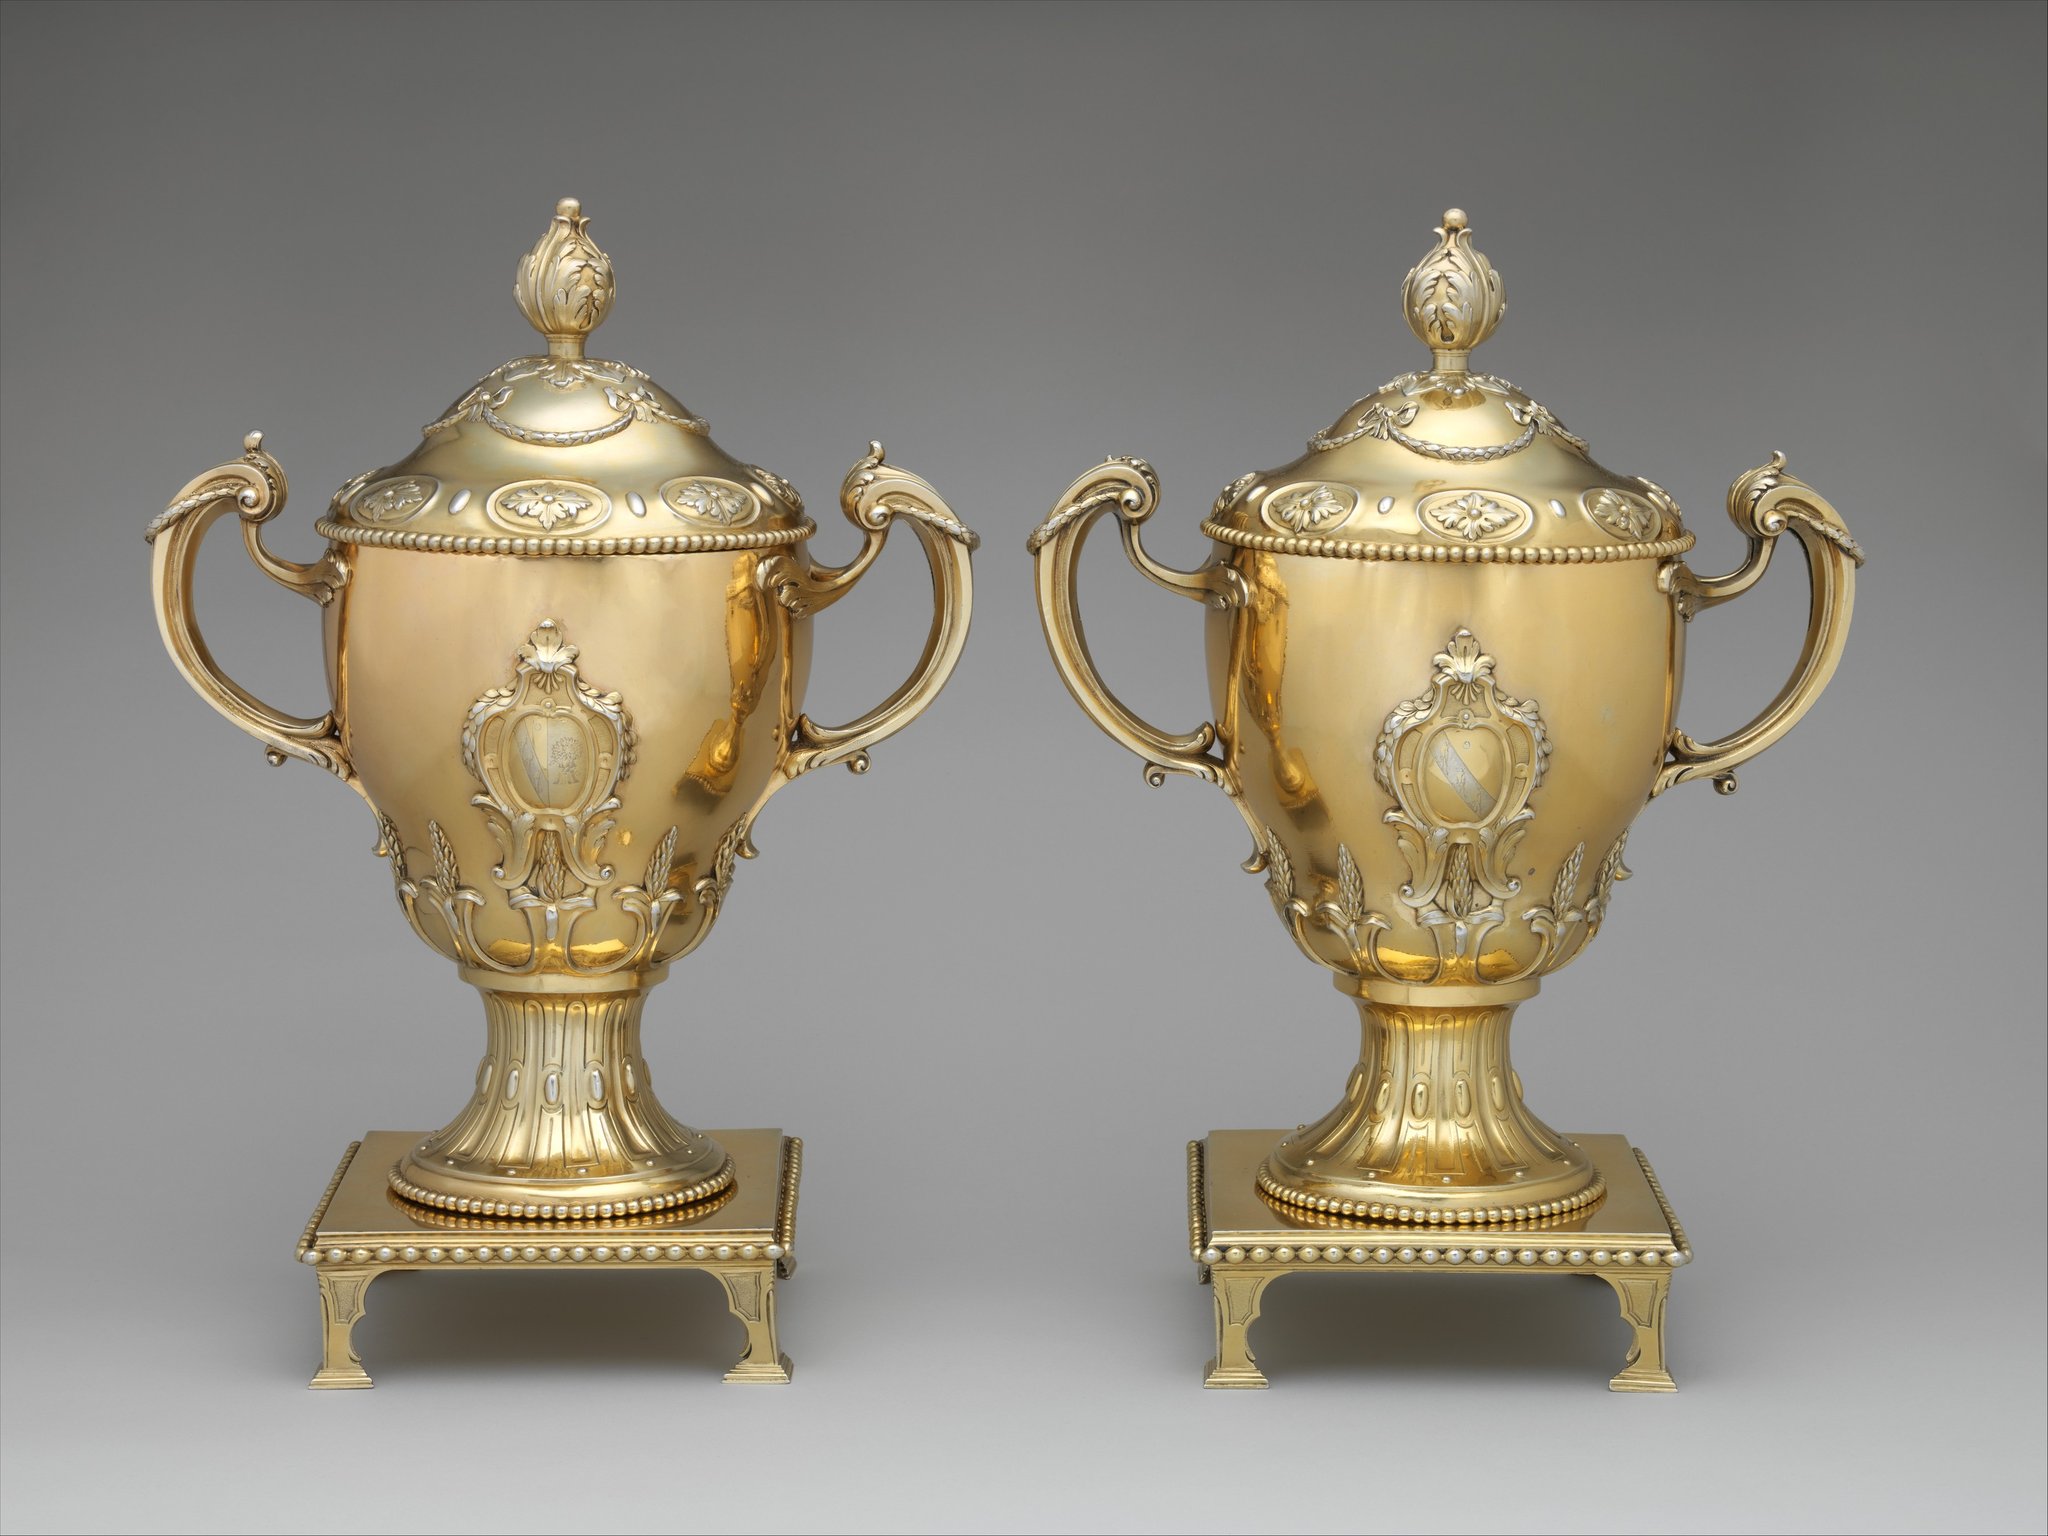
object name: cup with cover and stand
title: Cup with cover and stand (one of a pair)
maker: john parker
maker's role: maker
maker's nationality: british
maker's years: 1759-1777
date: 1766-1767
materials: silver gilt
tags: women